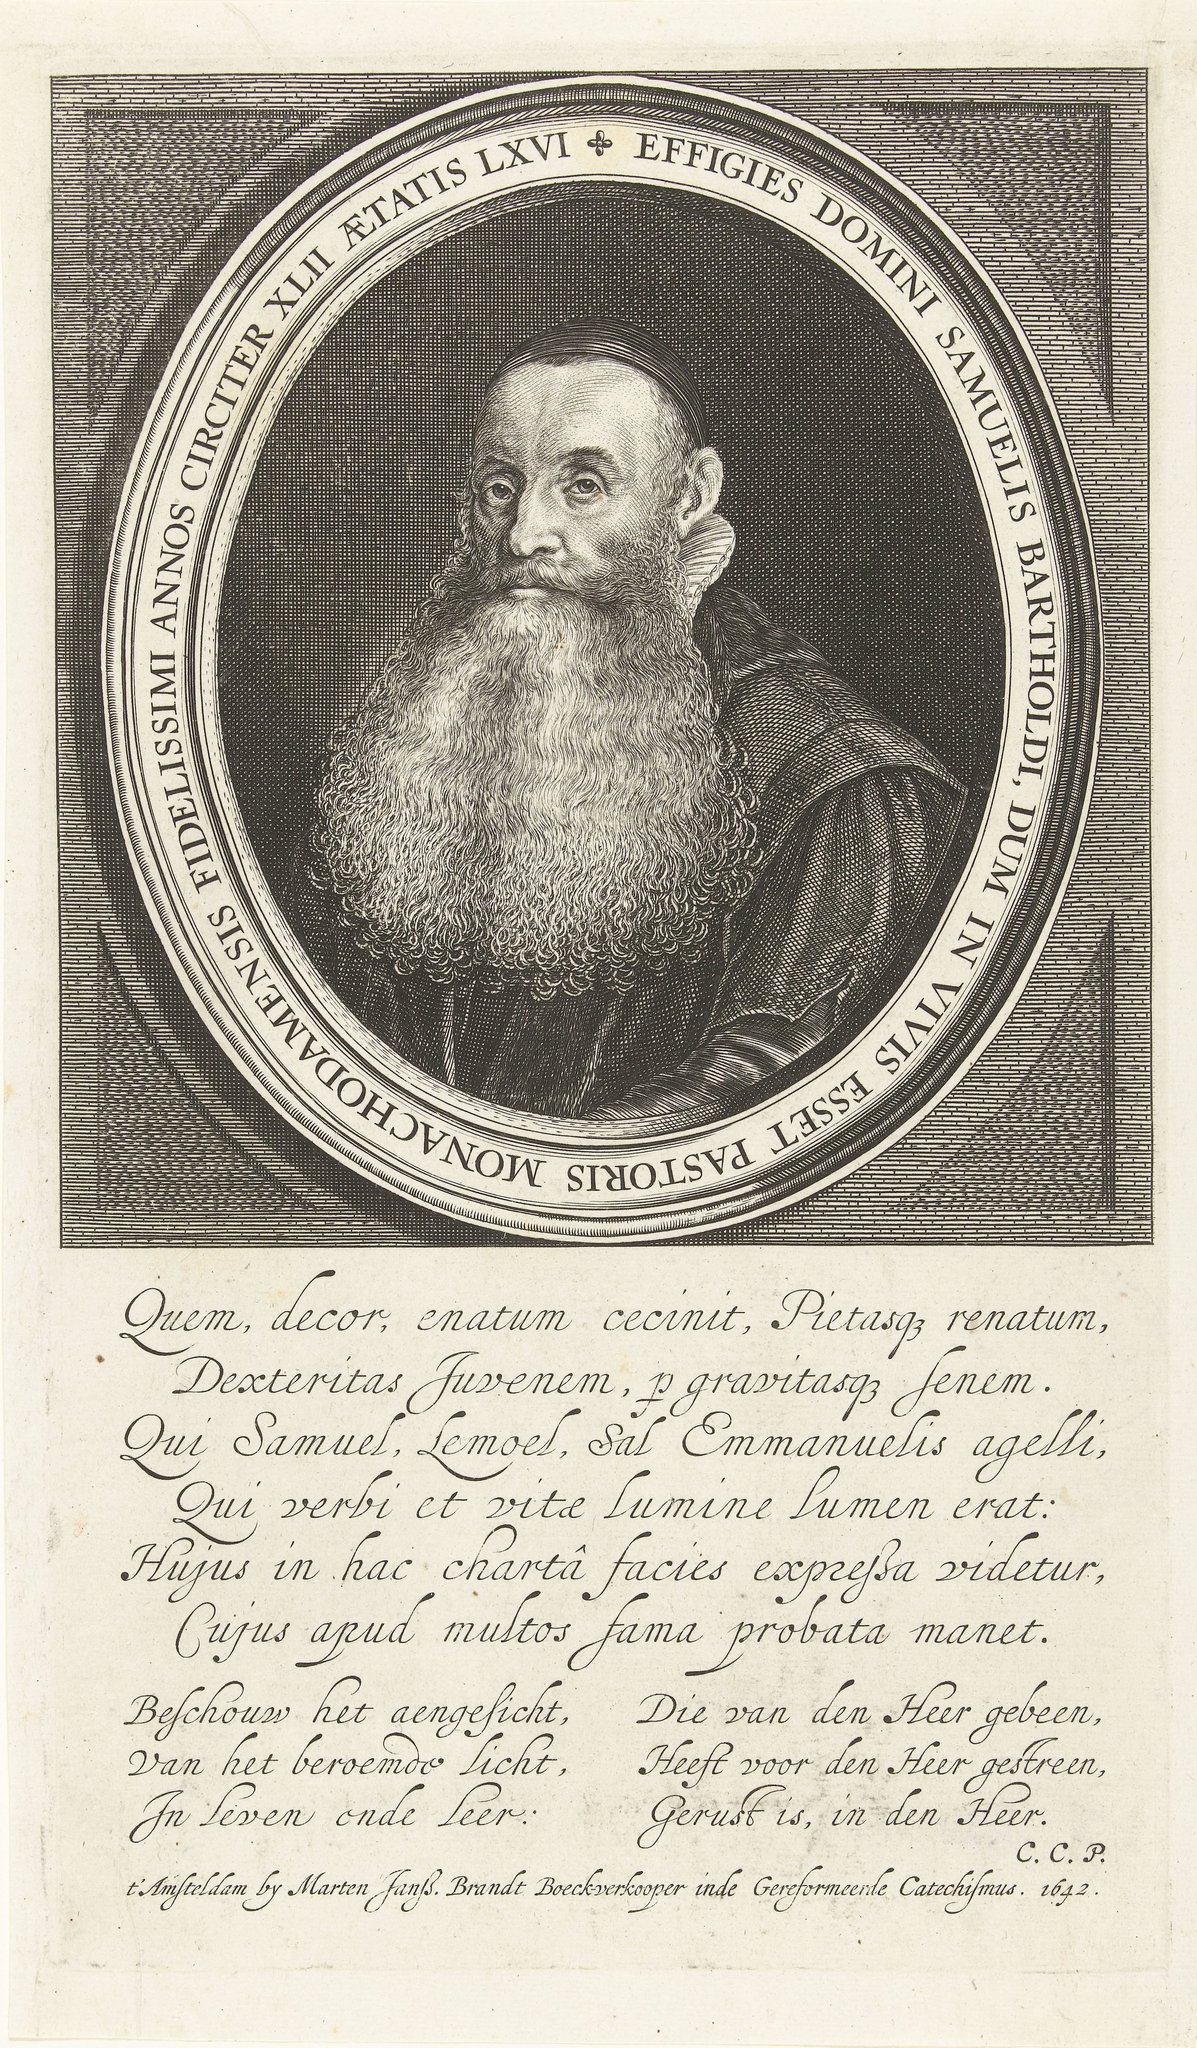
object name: print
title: Portret van Samuel Bartholdi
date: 1642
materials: paper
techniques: engraving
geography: amsterdam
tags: functionaries and dignitaries (with name) ~ episcopal protestant churches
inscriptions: collector's mark: Lugt 240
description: Portret van Samuel Bartholdi, borststuk met lange baard en toga in ovale omlijsting met Latijns opschrift. In ondermarge Latijns en Nederlands vers.